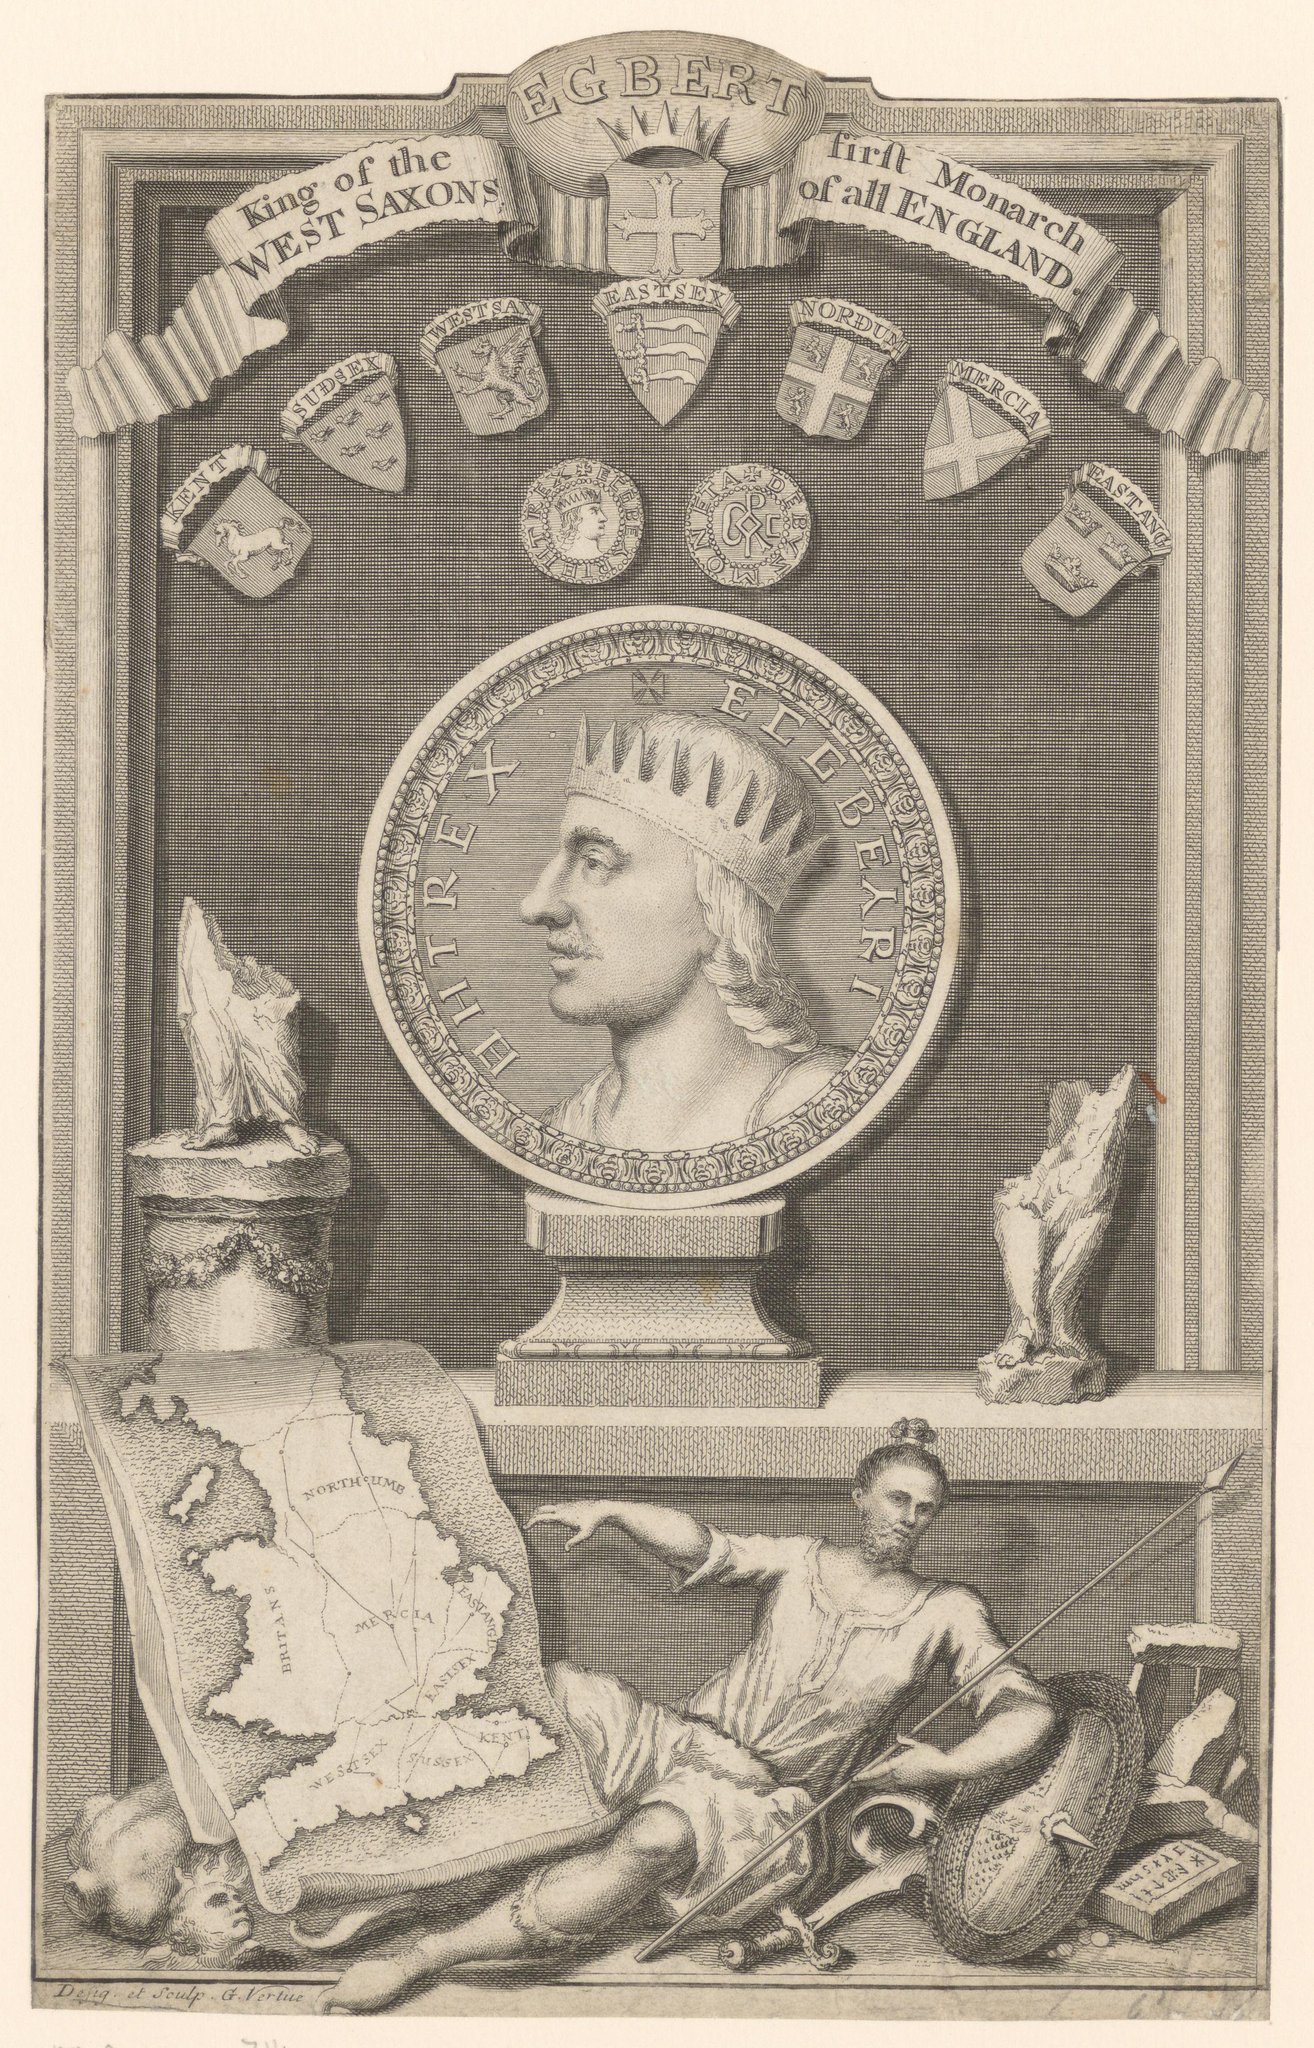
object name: print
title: Egbert, King of the West Saxons, first Monarch of all England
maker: george vertue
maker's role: print maker, publisher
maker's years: 1684-1756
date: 1694-1756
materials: paper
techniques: engraving, etching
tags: historical persons, king, armorial bearing, heraldry, england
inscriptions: collector's mark: Lugt 2228, collector's mark: Lugt 2228, collector's mark: Lugt 2228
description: Om het portretmedaillon wapenschilden en in de ondermarge een krijger en kaart van Engeland.